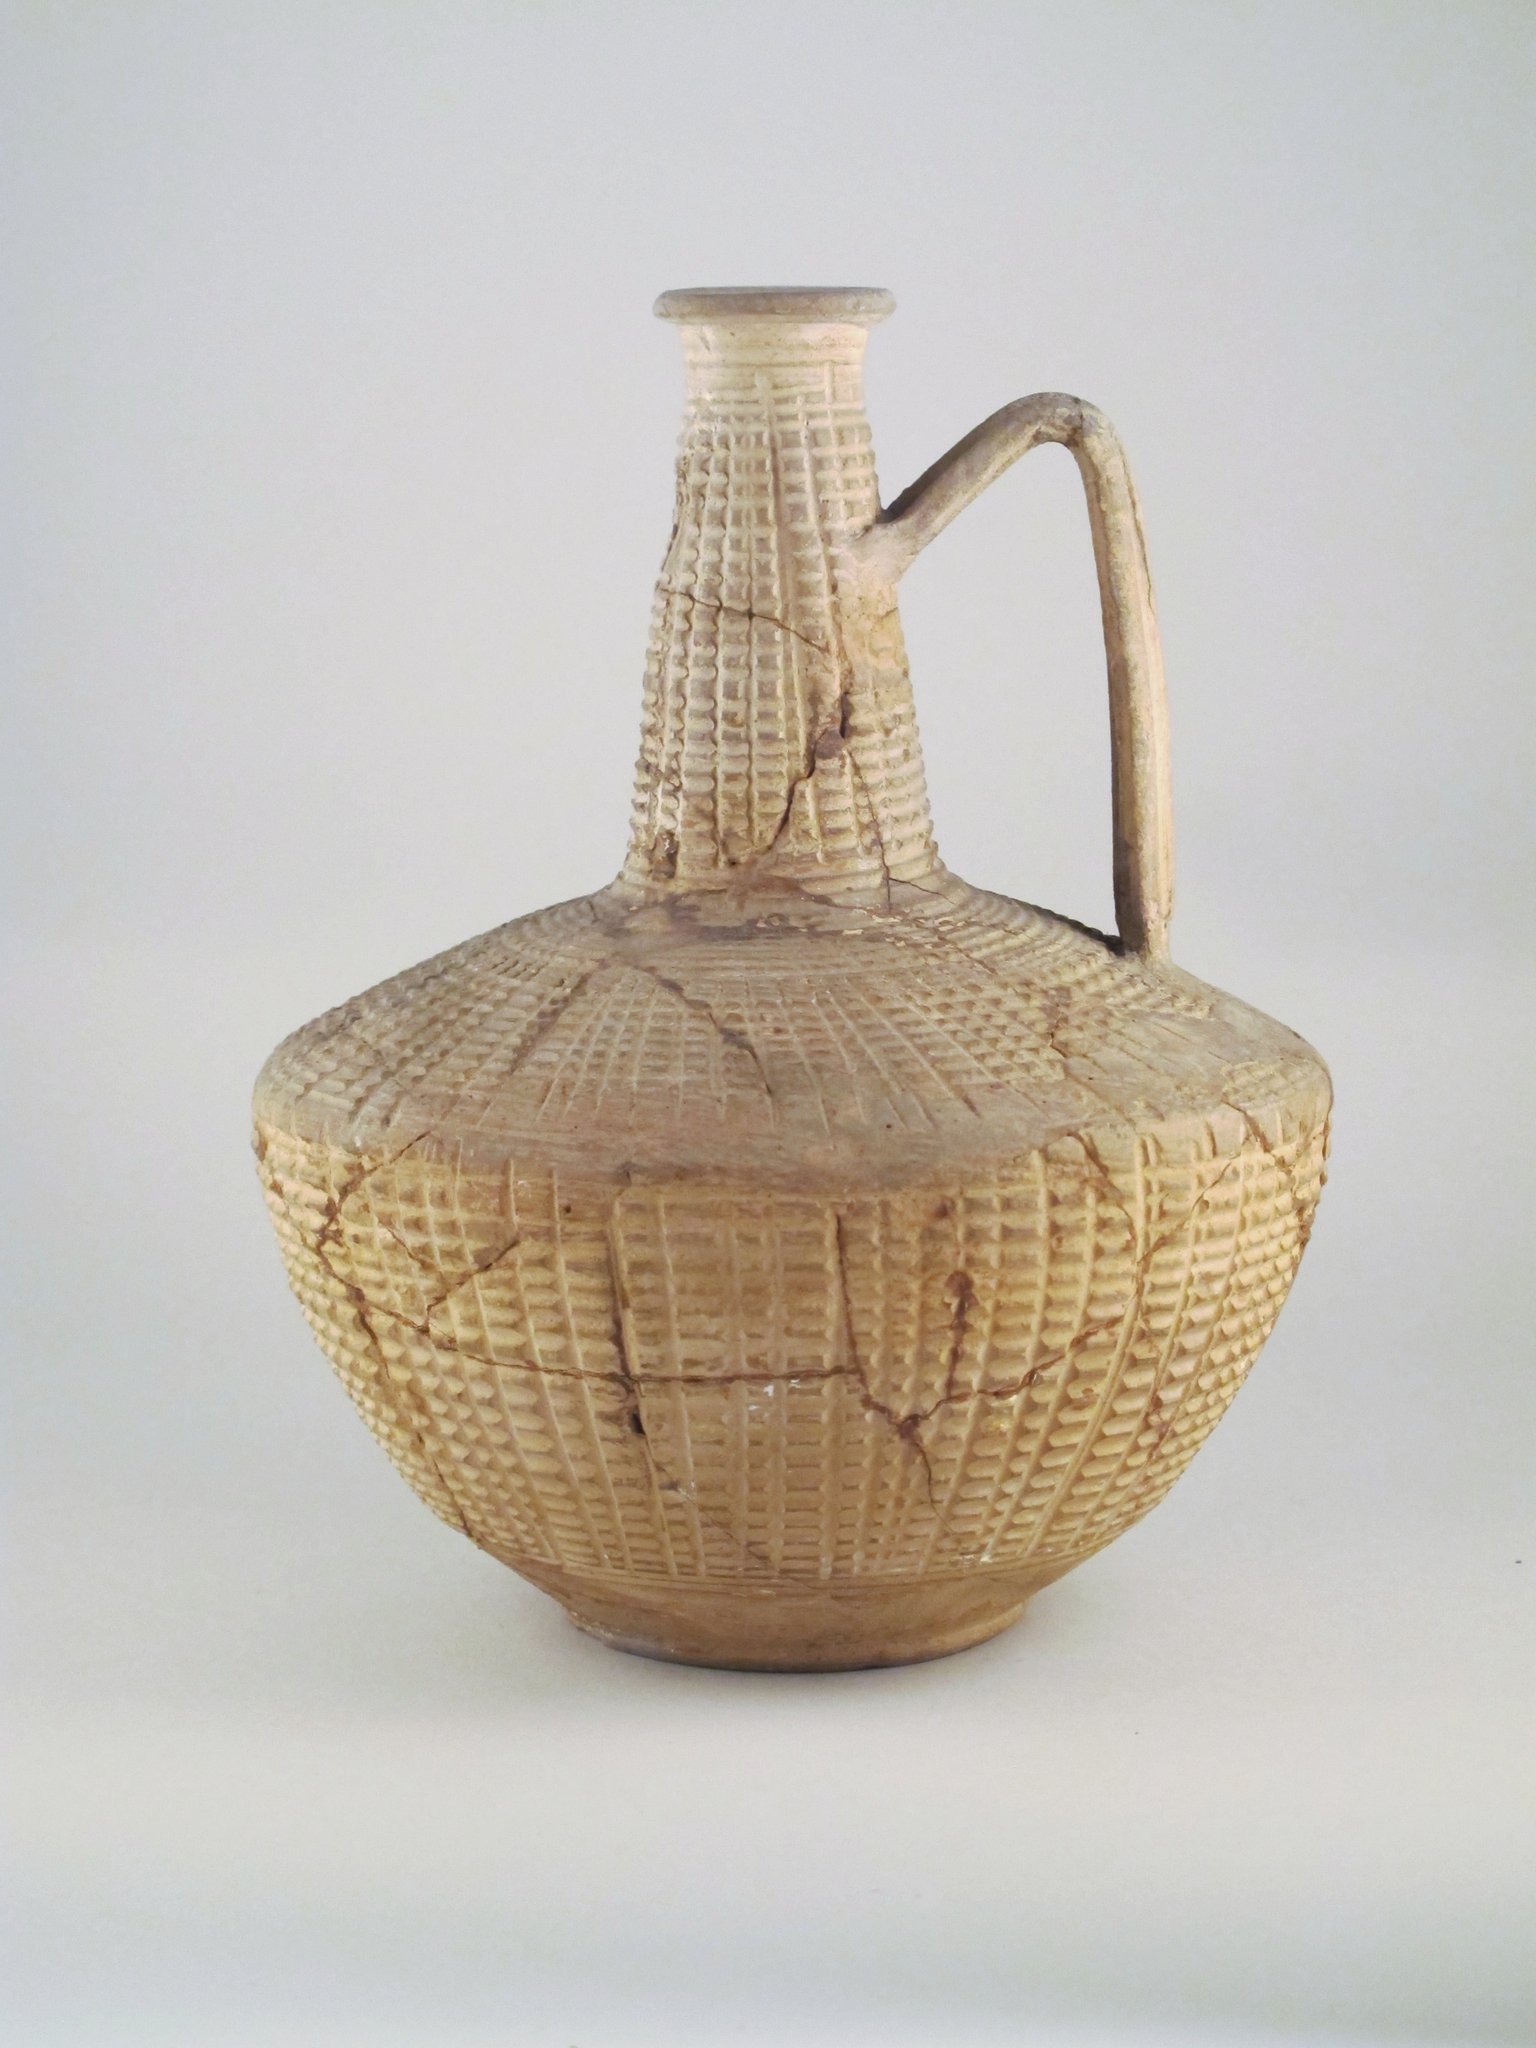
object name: vase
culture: roman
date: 670 BCE-330 CE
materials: terracotta